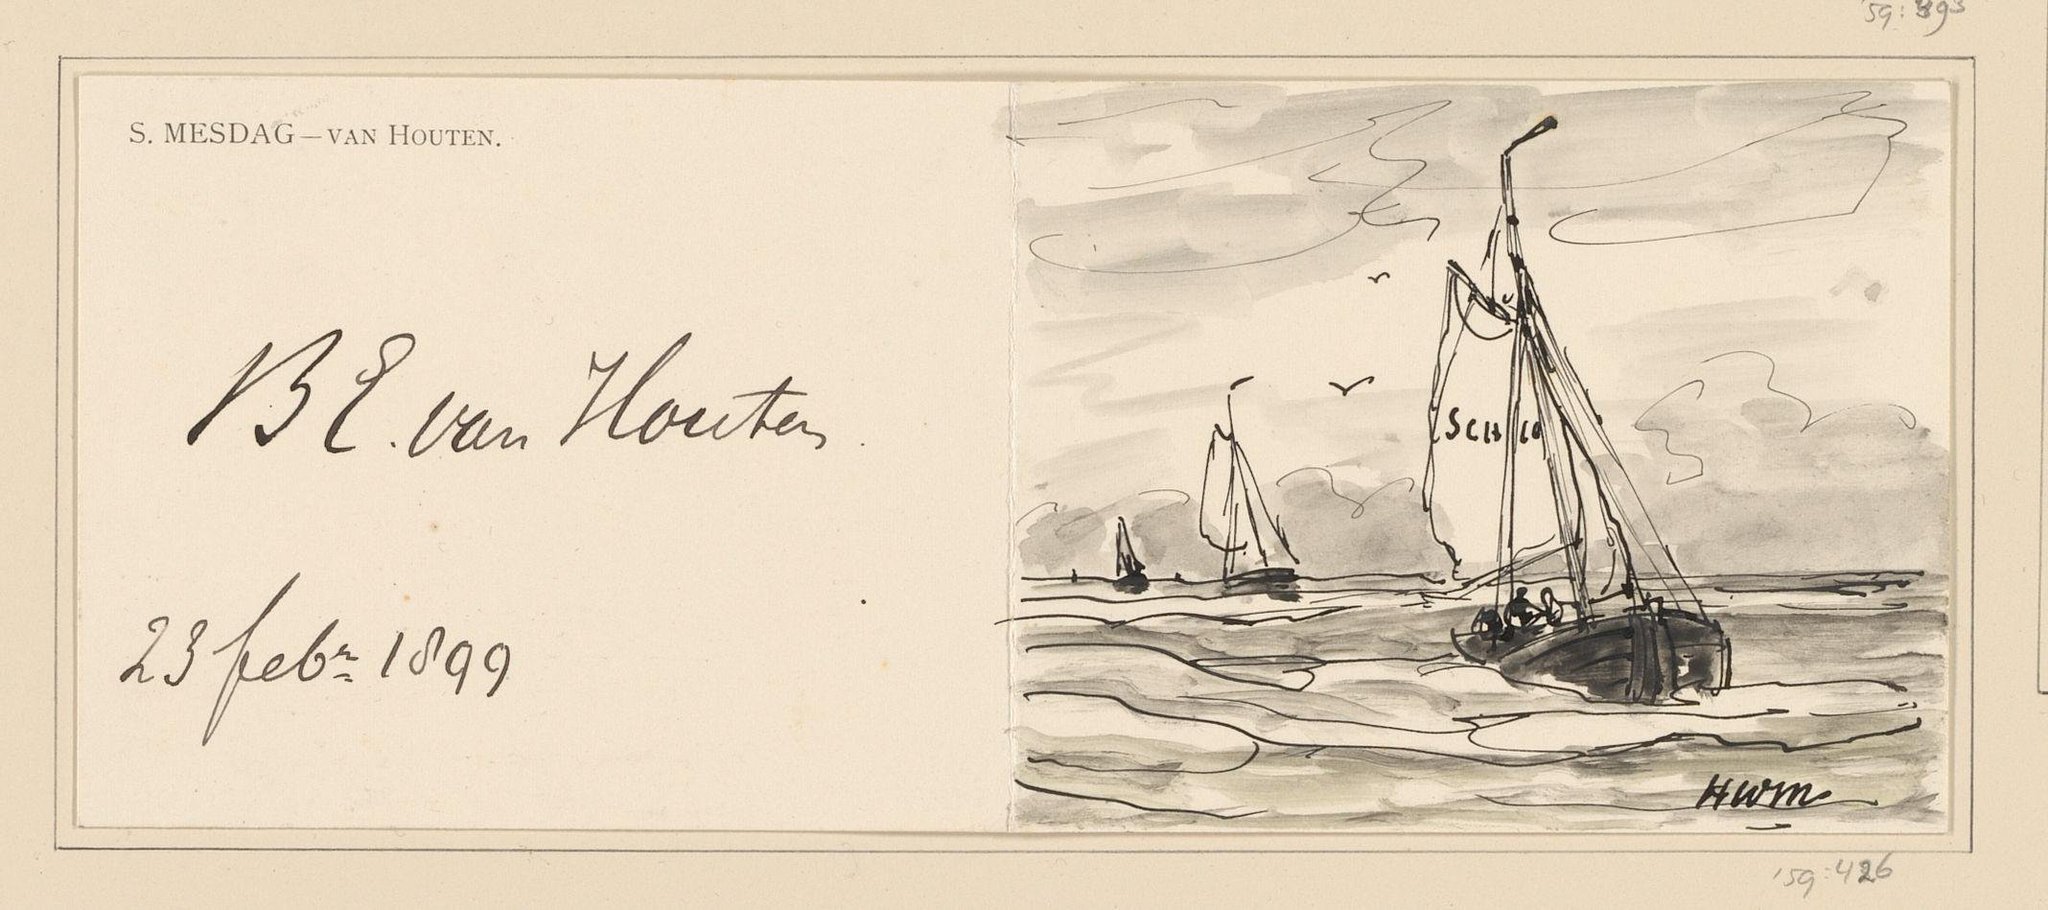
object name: drawing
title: Zeegezicht met zeilboten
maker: hendrik willem mesdag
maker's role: draughtsman, painter, print maker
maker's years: 1831-1915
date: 1899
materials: ink, paper, watercolor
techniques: brush, letterpress printing, pen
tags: sailing-ship, sailing-boat, sea (seascape)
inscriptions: inscription: ‘BE[?] van Houten/ 23 febr 1899’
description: Tekening op een gepersonaliseerde kaart met linksboven de naam van Sientje Mesdag-van Houten.